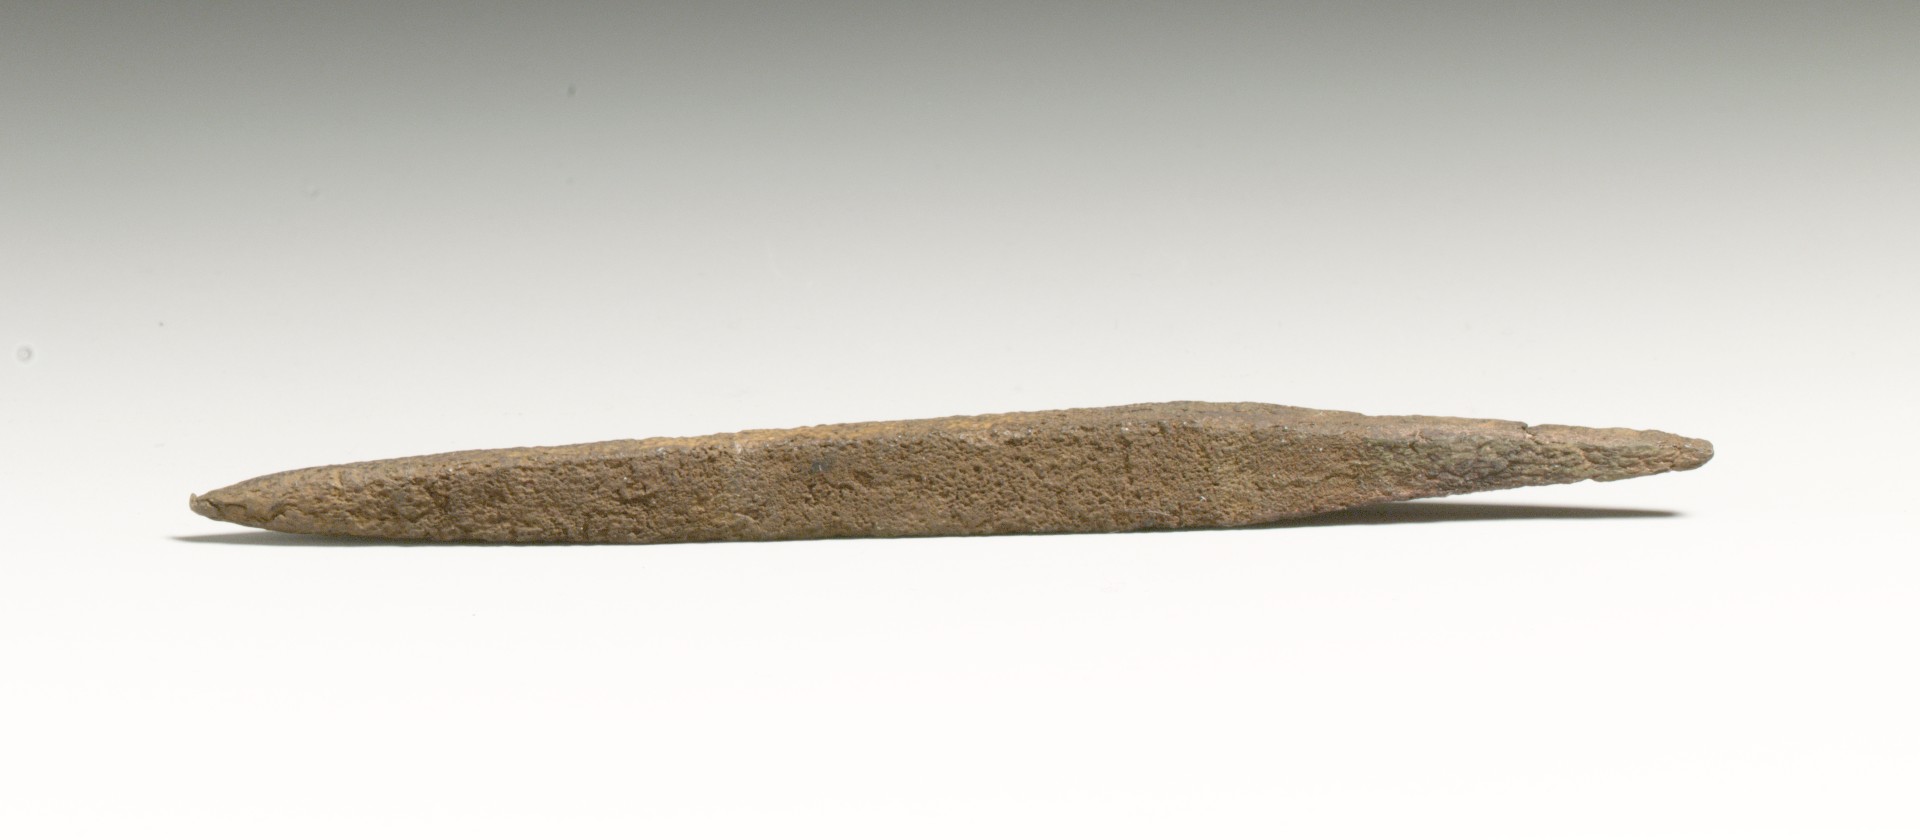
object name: awl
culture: cypriot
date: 3900 BCE-100 CE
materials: bronze